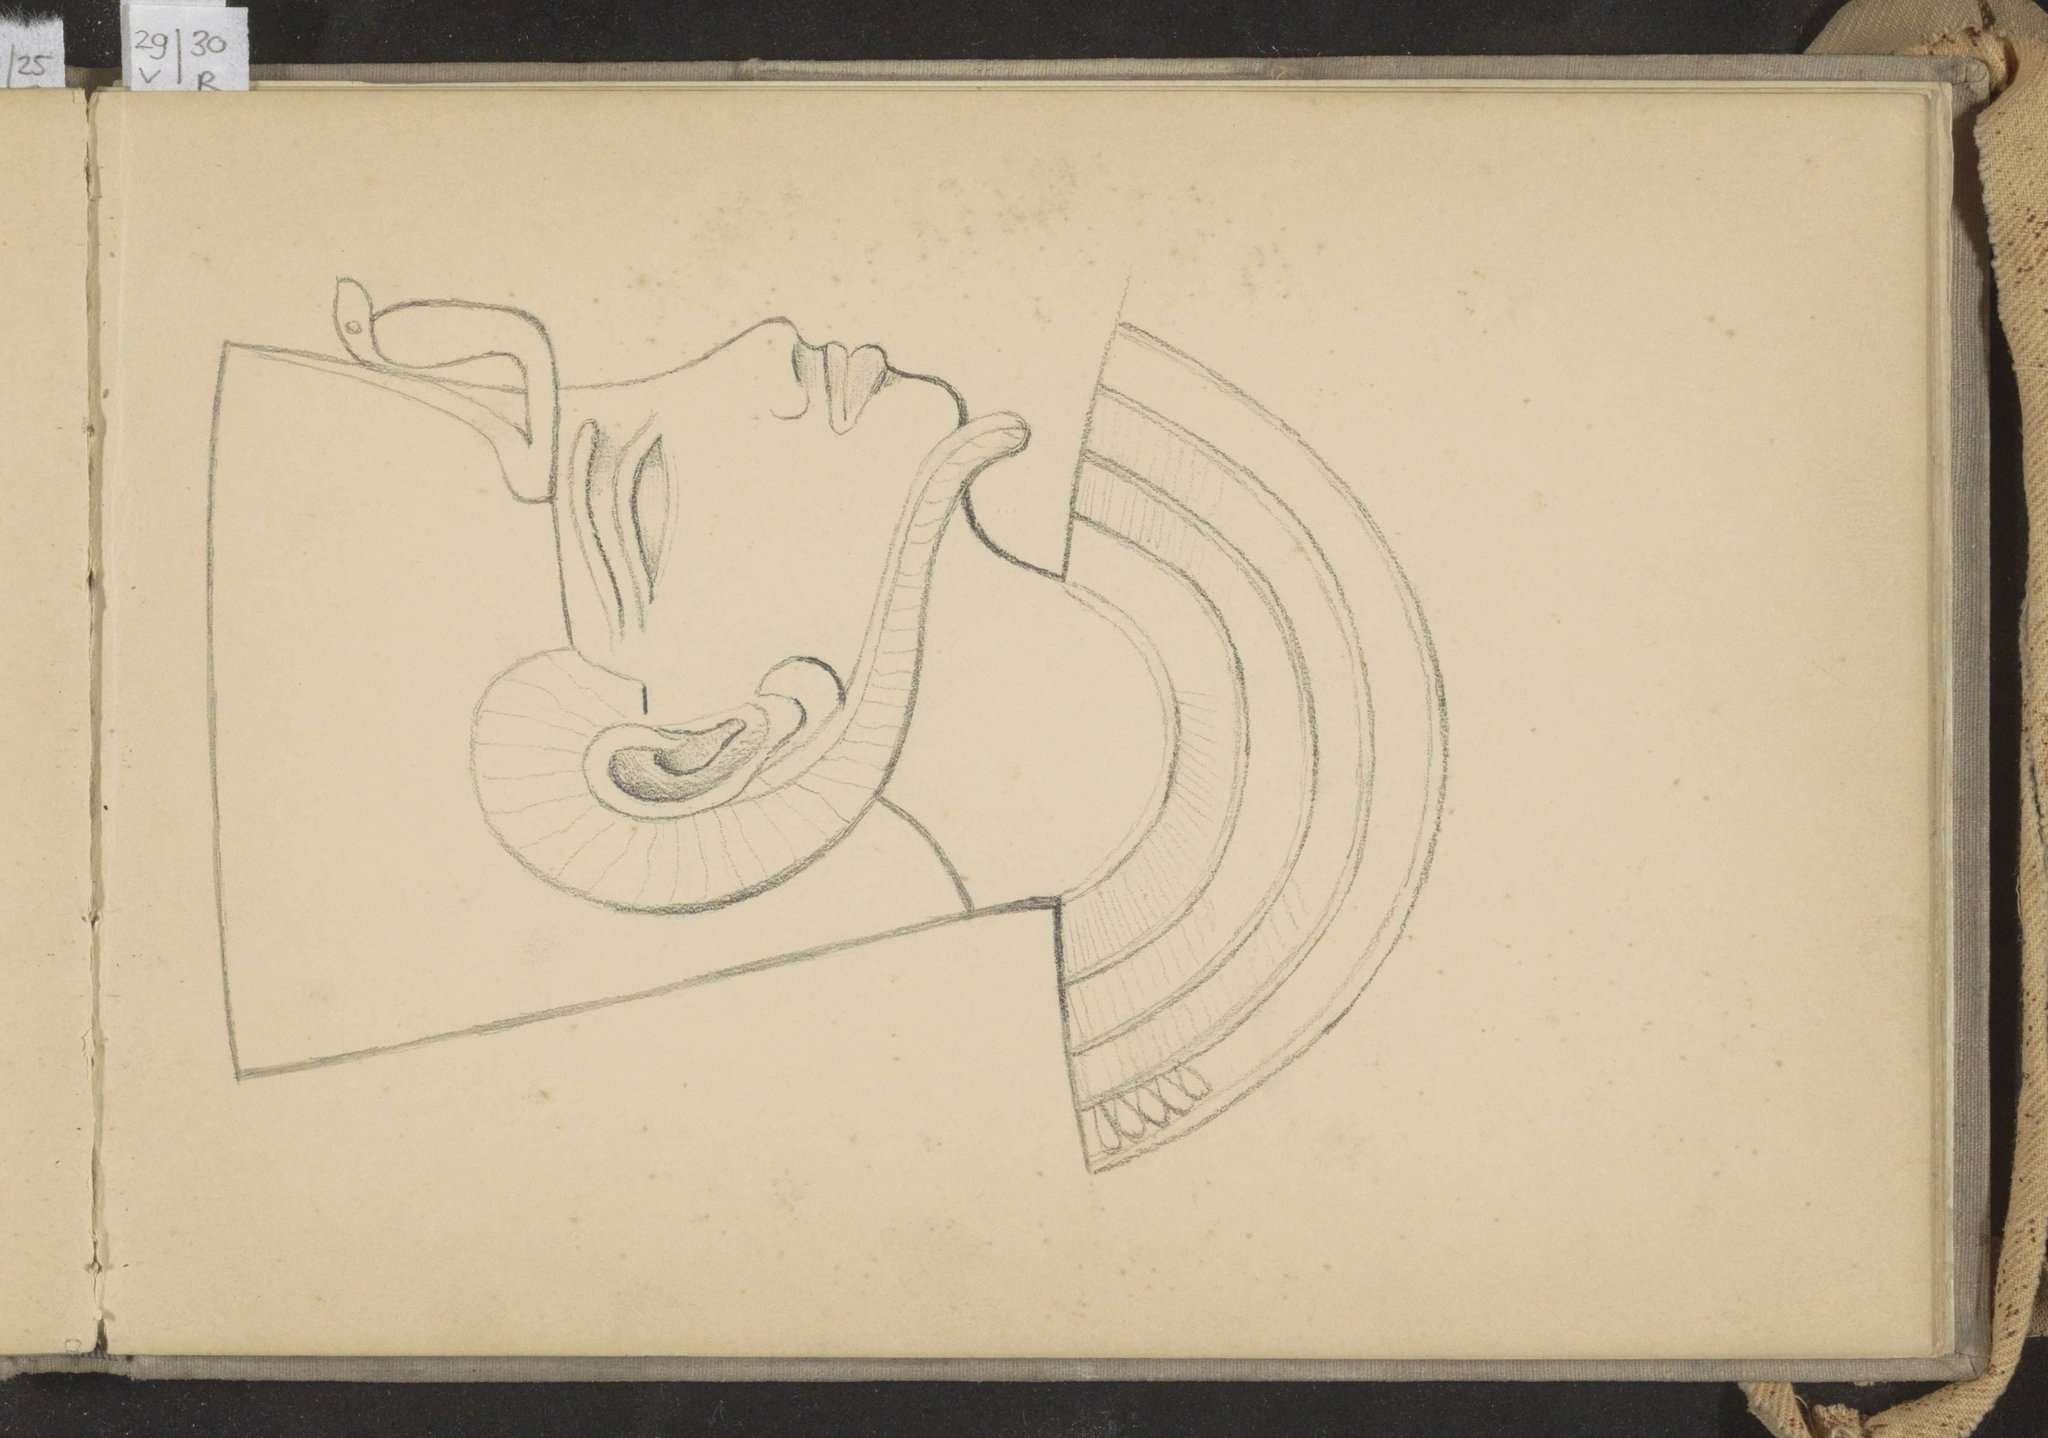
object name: sketchbook leaf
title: Hoofd van een farao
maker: johanna van de kamer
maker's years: 1873-1922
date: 1890-1922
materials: paper, pencil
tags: ruler, sovereign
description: De farao draagt een hoofddeksel met slang. Blad 29 recto uit een schetsboek met 43 bladen.